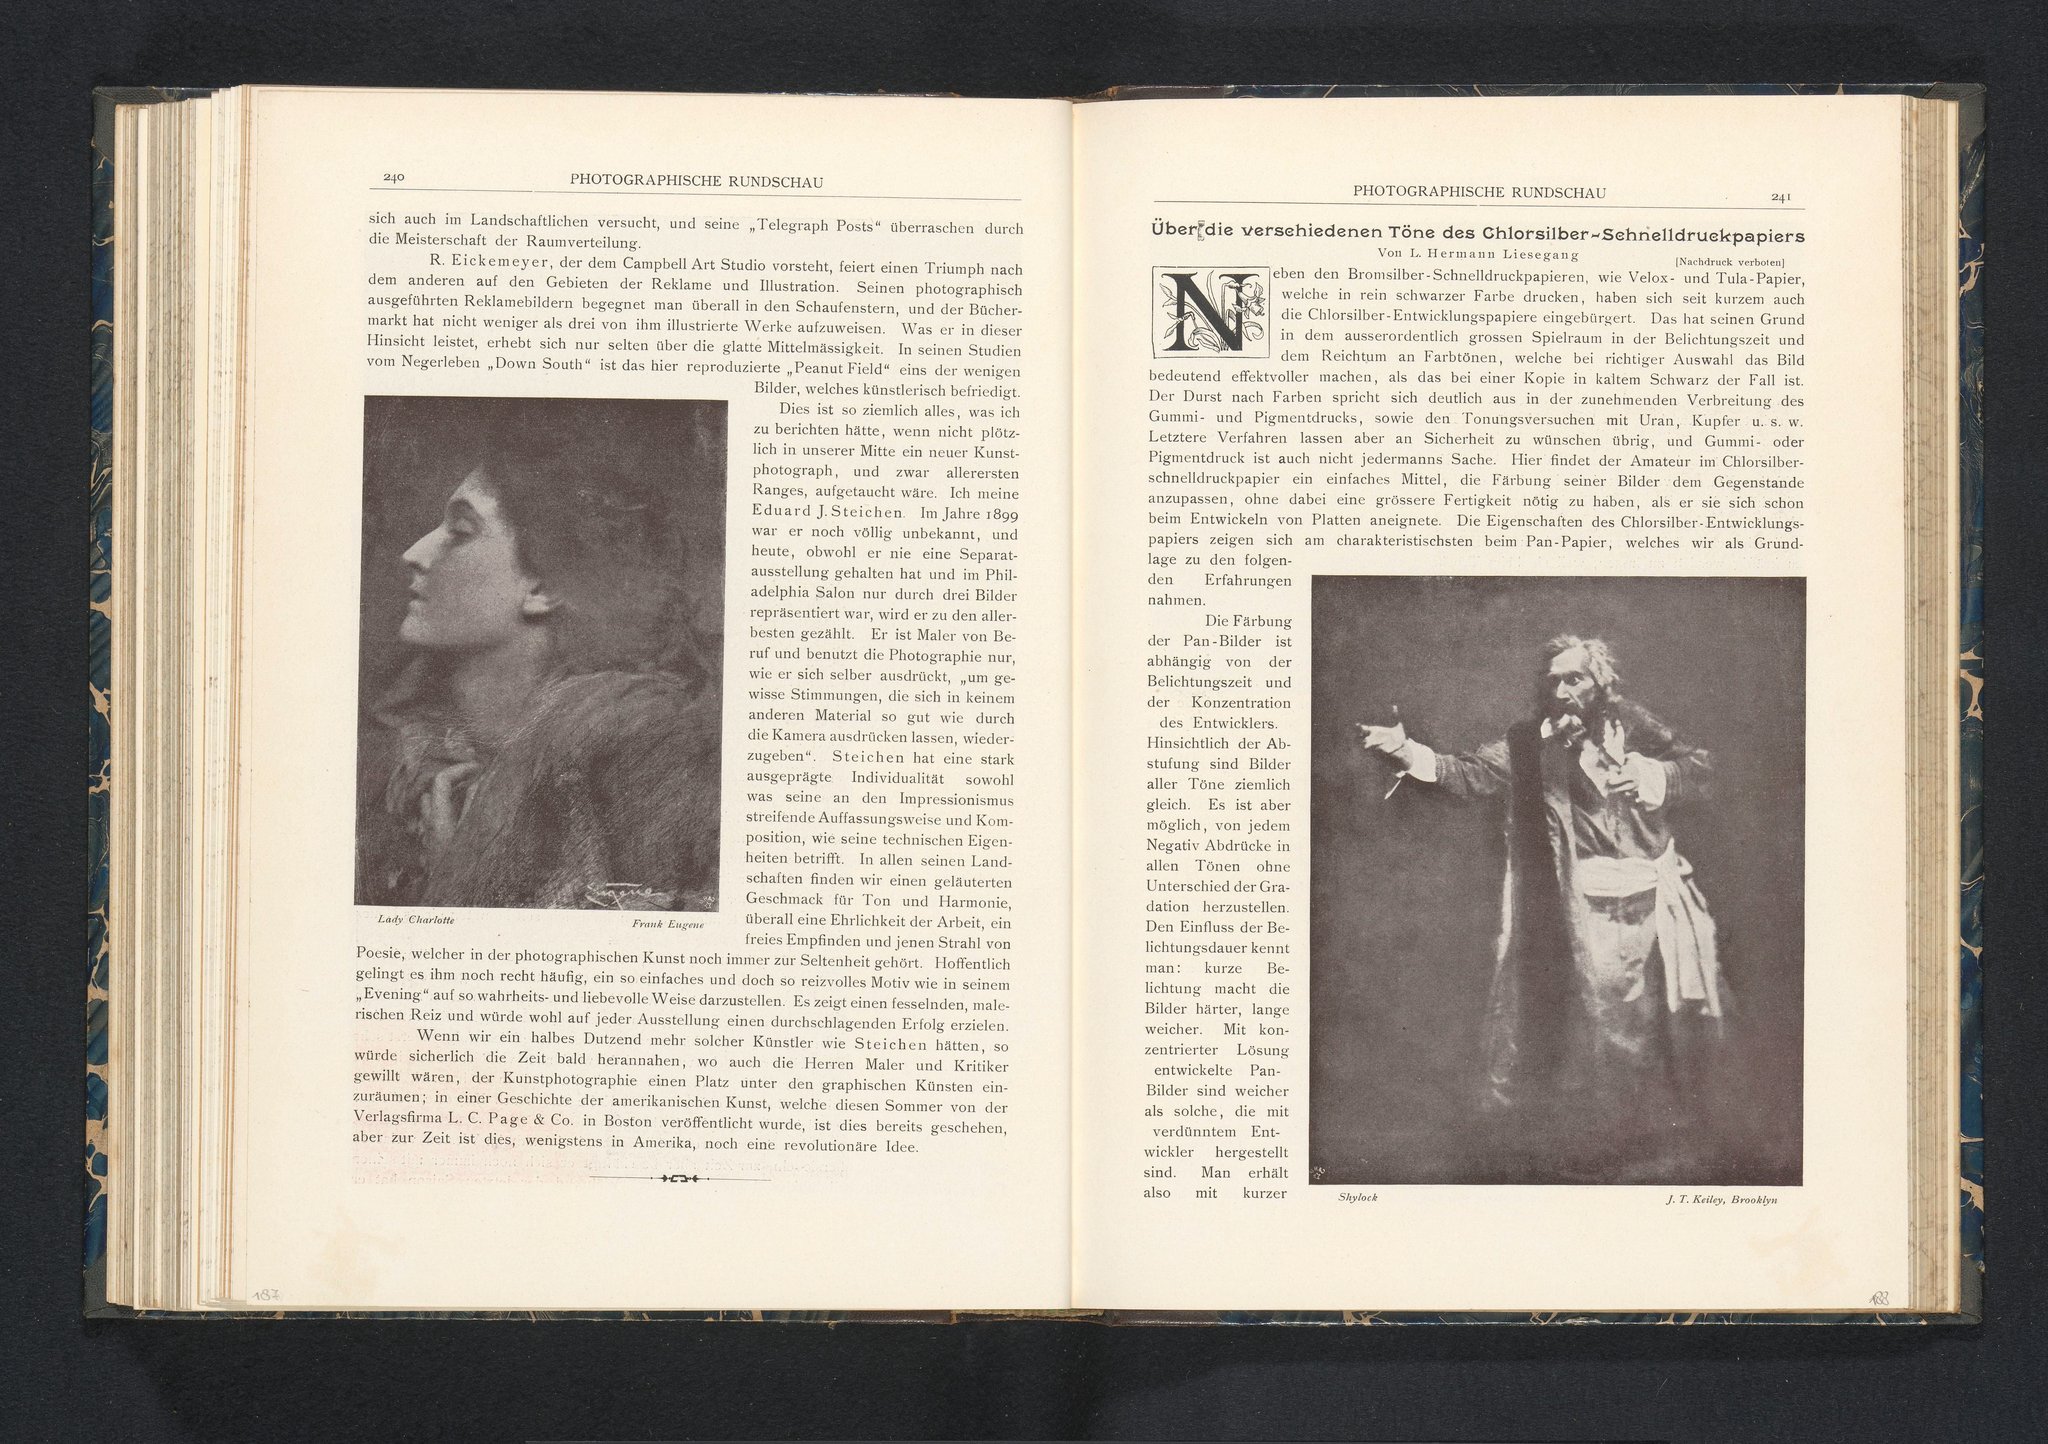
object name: photomechanical print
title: Portret van een onbekende vrouw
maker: frank eugene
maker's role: fotograaf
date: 1896-1901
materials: paper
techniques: autotype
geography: berlin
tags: historical persons not known by name - bb - woman